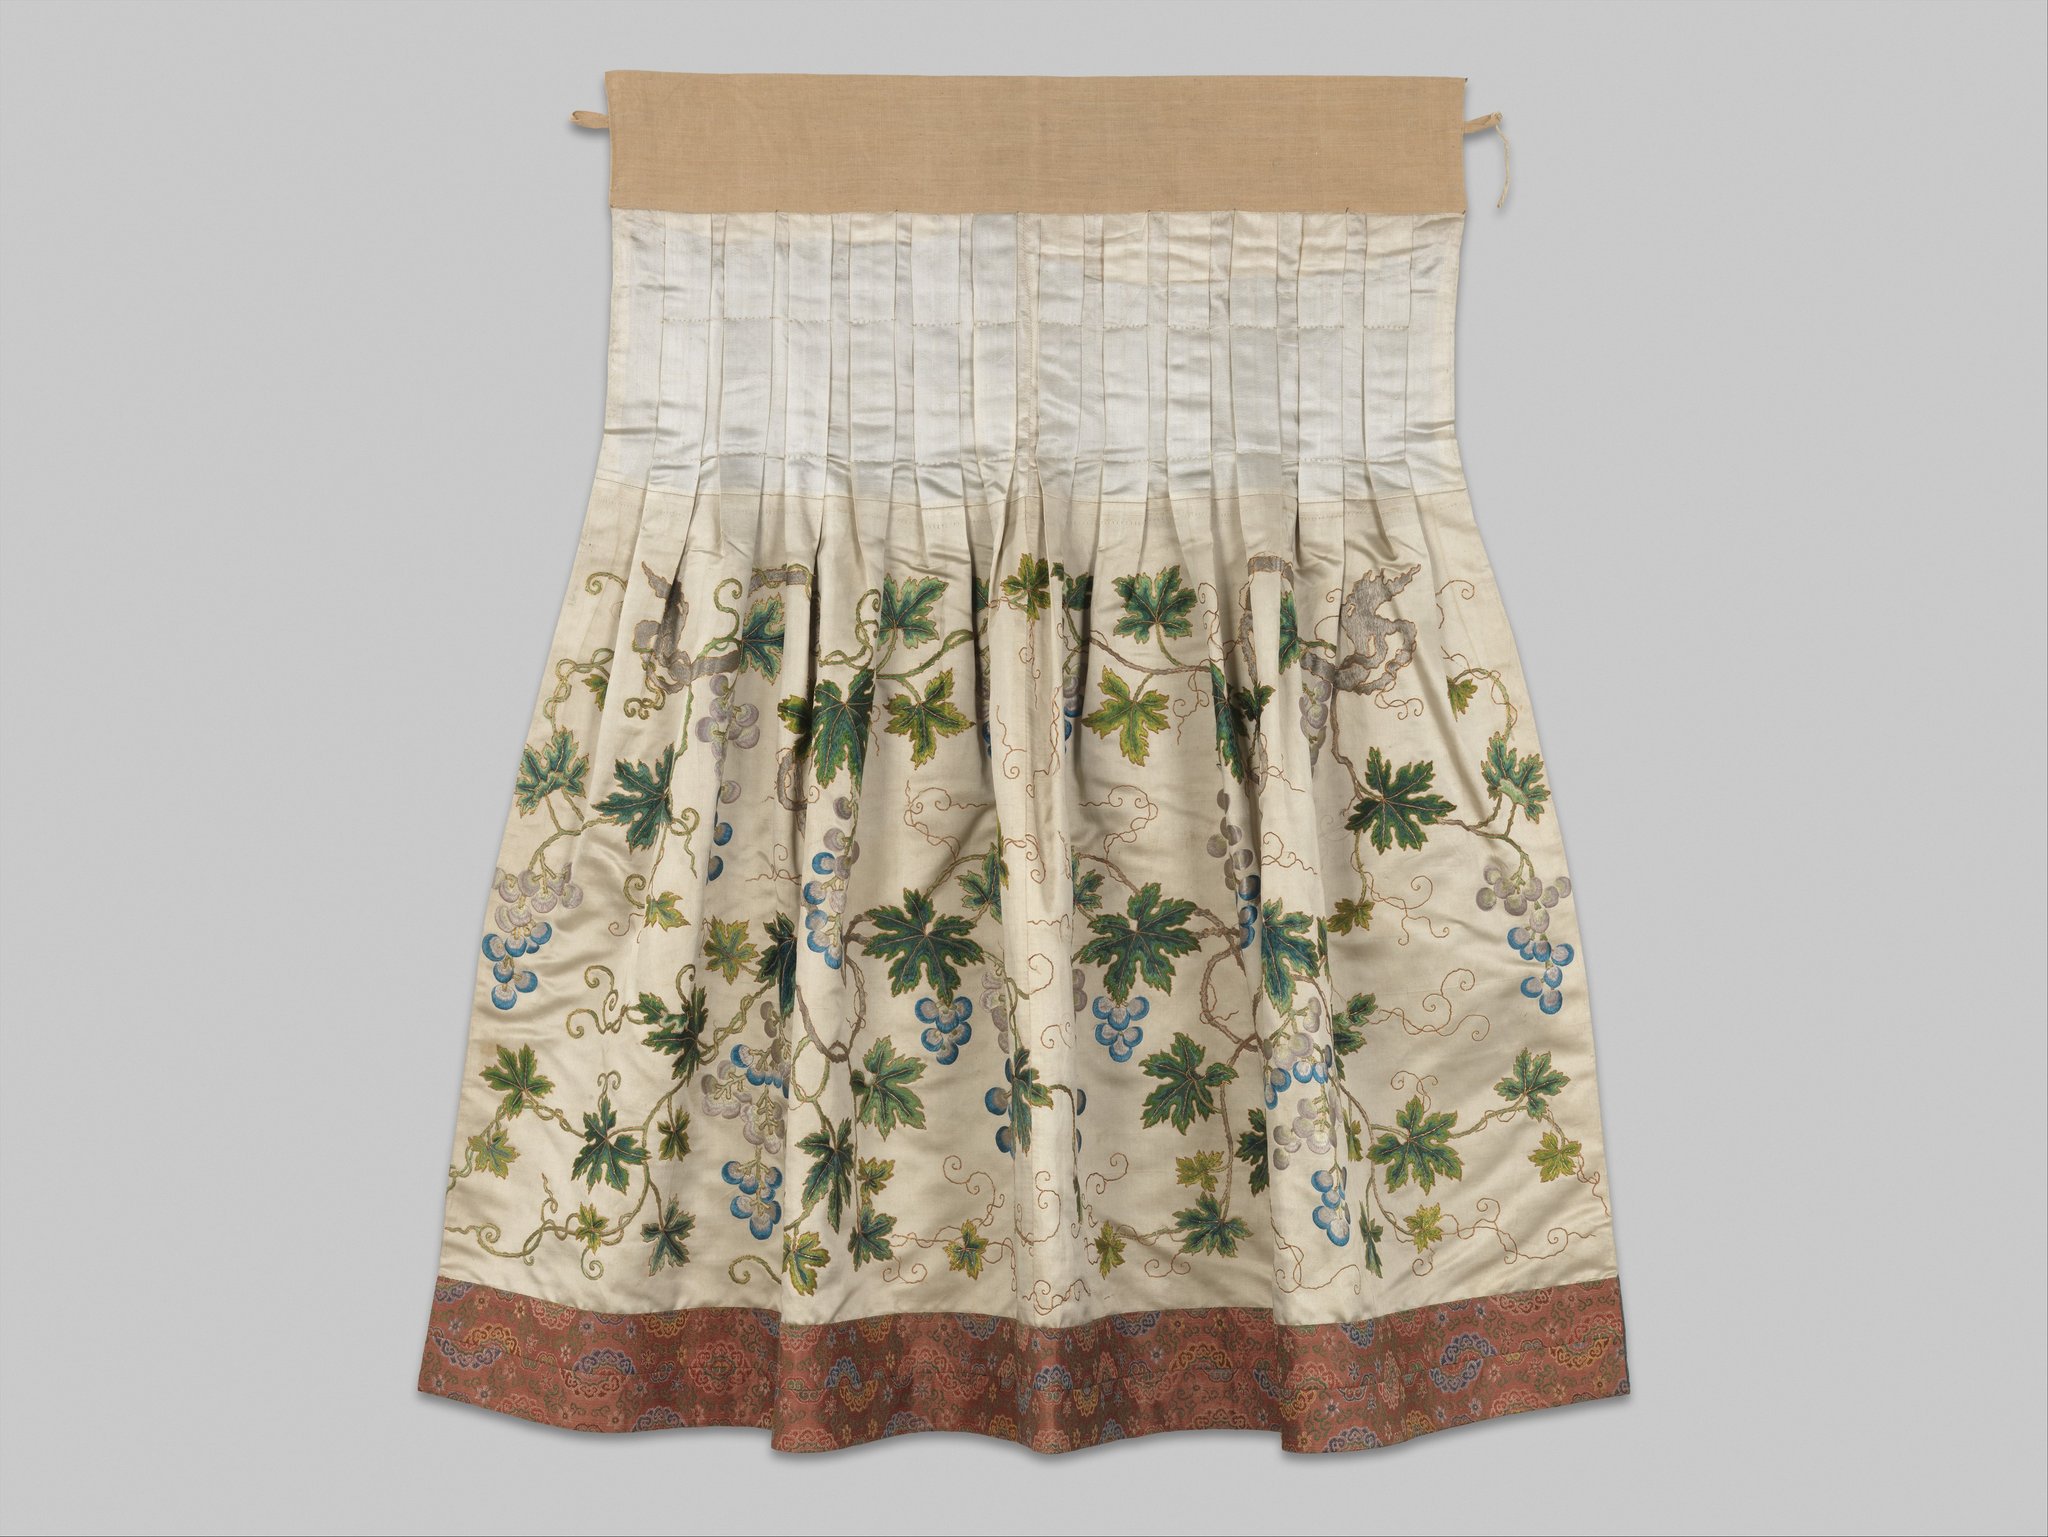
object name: skirt, imperial theatrical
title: Theatrical skirt with grapevines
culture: chinese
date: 1701-1800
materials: metal thread, silk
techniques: brocade, embroidery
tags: leaves